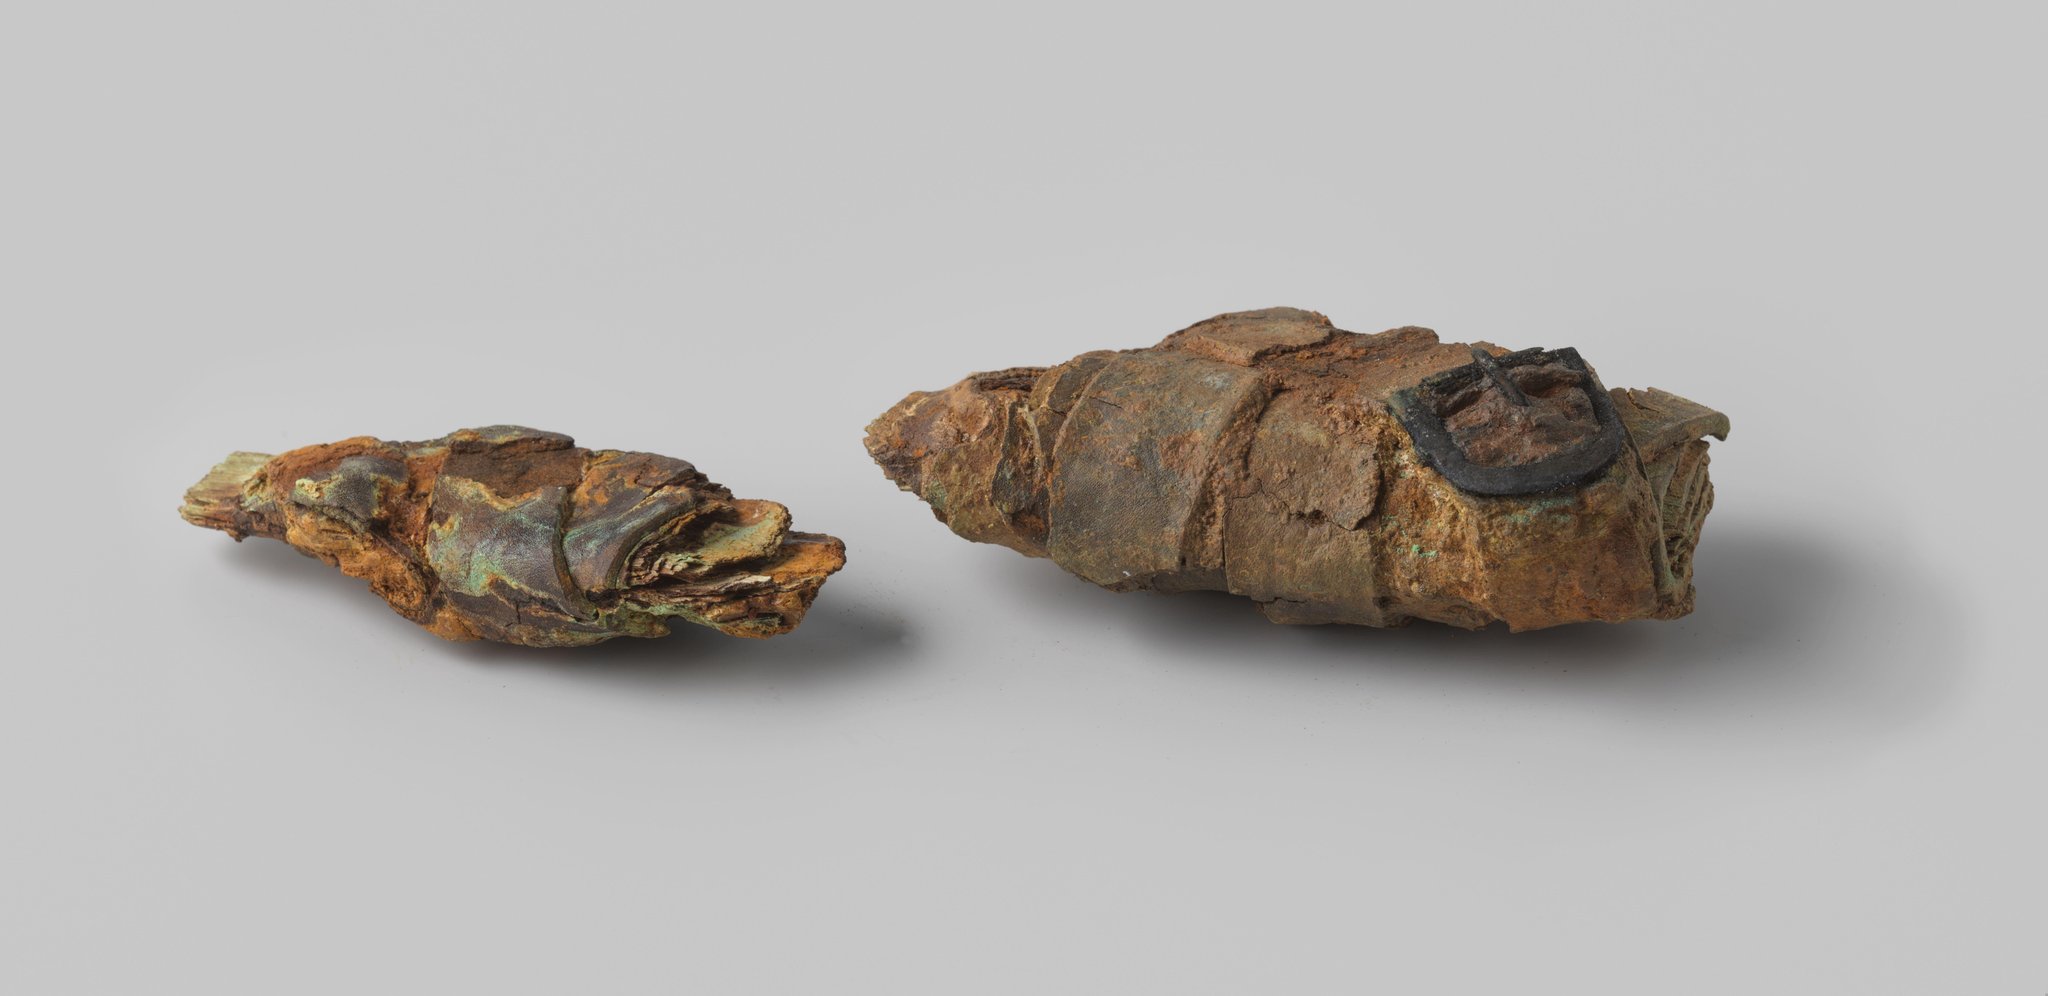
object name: knife with sheath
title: Fragmenten schedes uit het wrak van de Oost-Indiëvaarder Hollandia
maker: Anonymous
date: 1700-1743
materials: copper, leather, wood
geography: netherlands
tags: verenigde oostindische compagnie, hollandia (schip), annet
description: Fragm: fragm of top end, wood core with leather cover, leather belt with copper buckle (id. buckle NG 1980-27H537) wrapped around; fragm id. NG 1980-27H 1832, both ends broken.